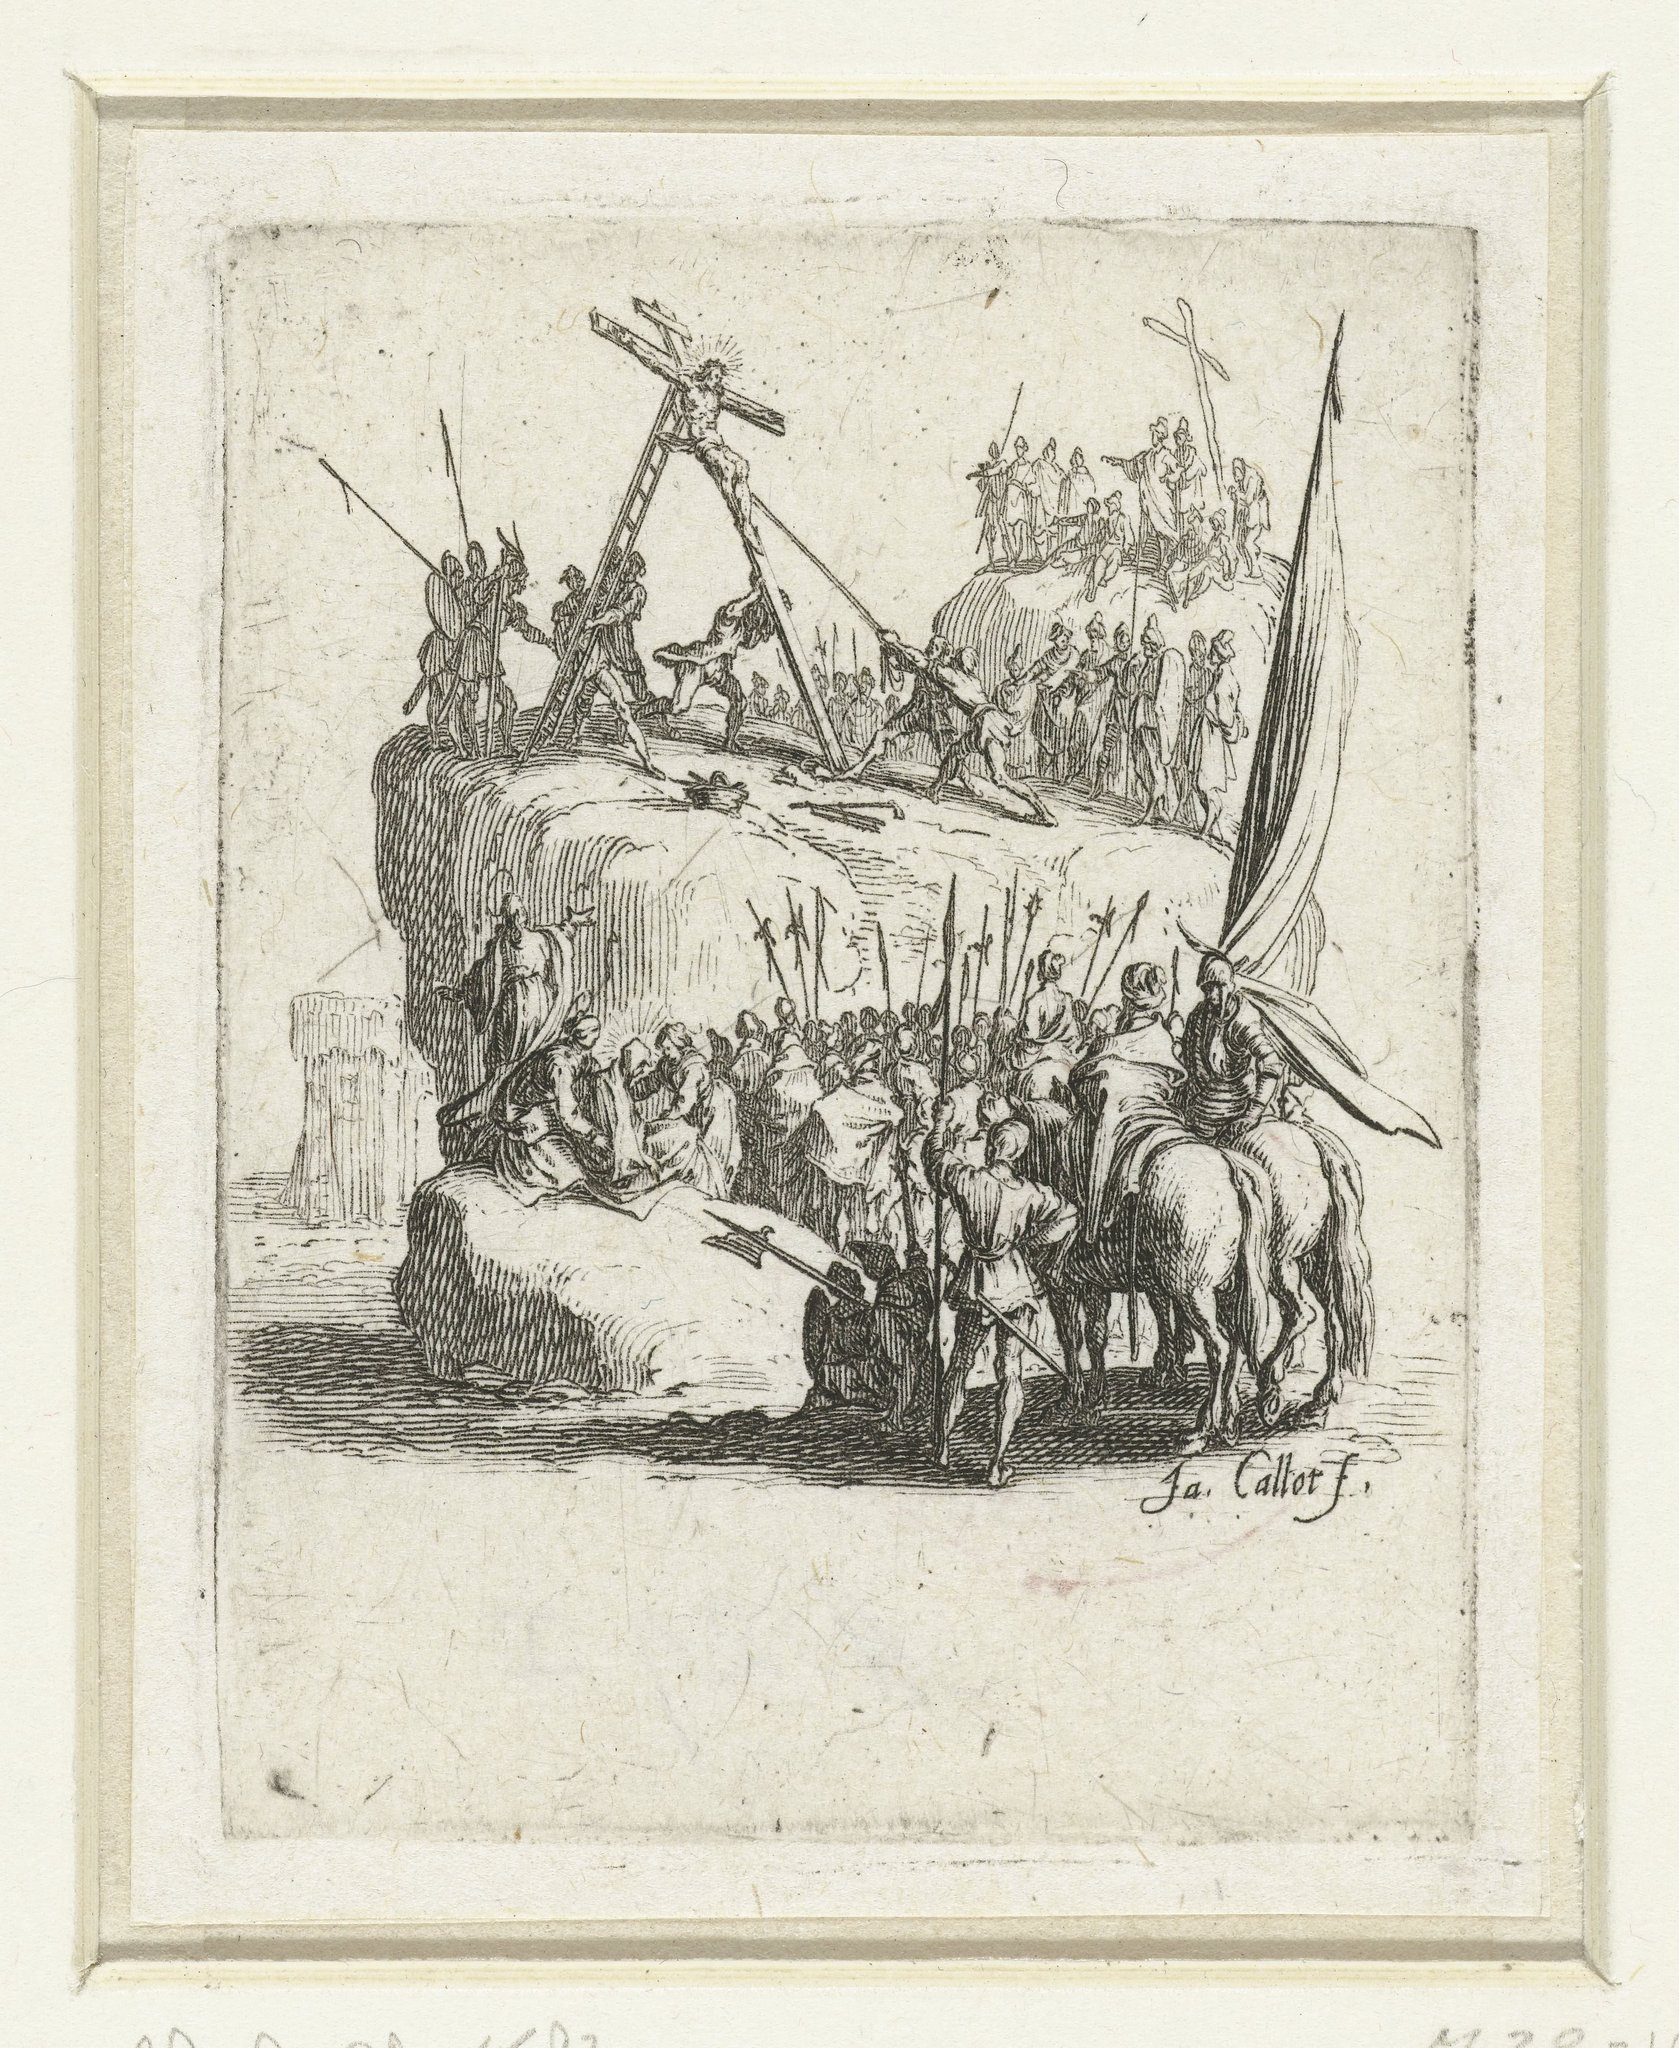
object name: print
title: De kleine Passie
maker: jacques callot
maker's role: draughtsman, print maker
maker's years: 1592-1635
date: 1624-1625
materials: paper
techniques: etching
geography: nancy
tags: raising of the cross to which christ is nailed already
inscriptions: collector's mark: Lugt 240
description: Het kruis met Christus eraan wordt door een aantal mannen overeind getrokken/geduwd. Enkele groepen mensen kijken toe. Deze prent is onderdeel van de prentserie 'De kleine Passie', bestaande uit 12 scènes uit het Lijdensverhaal.